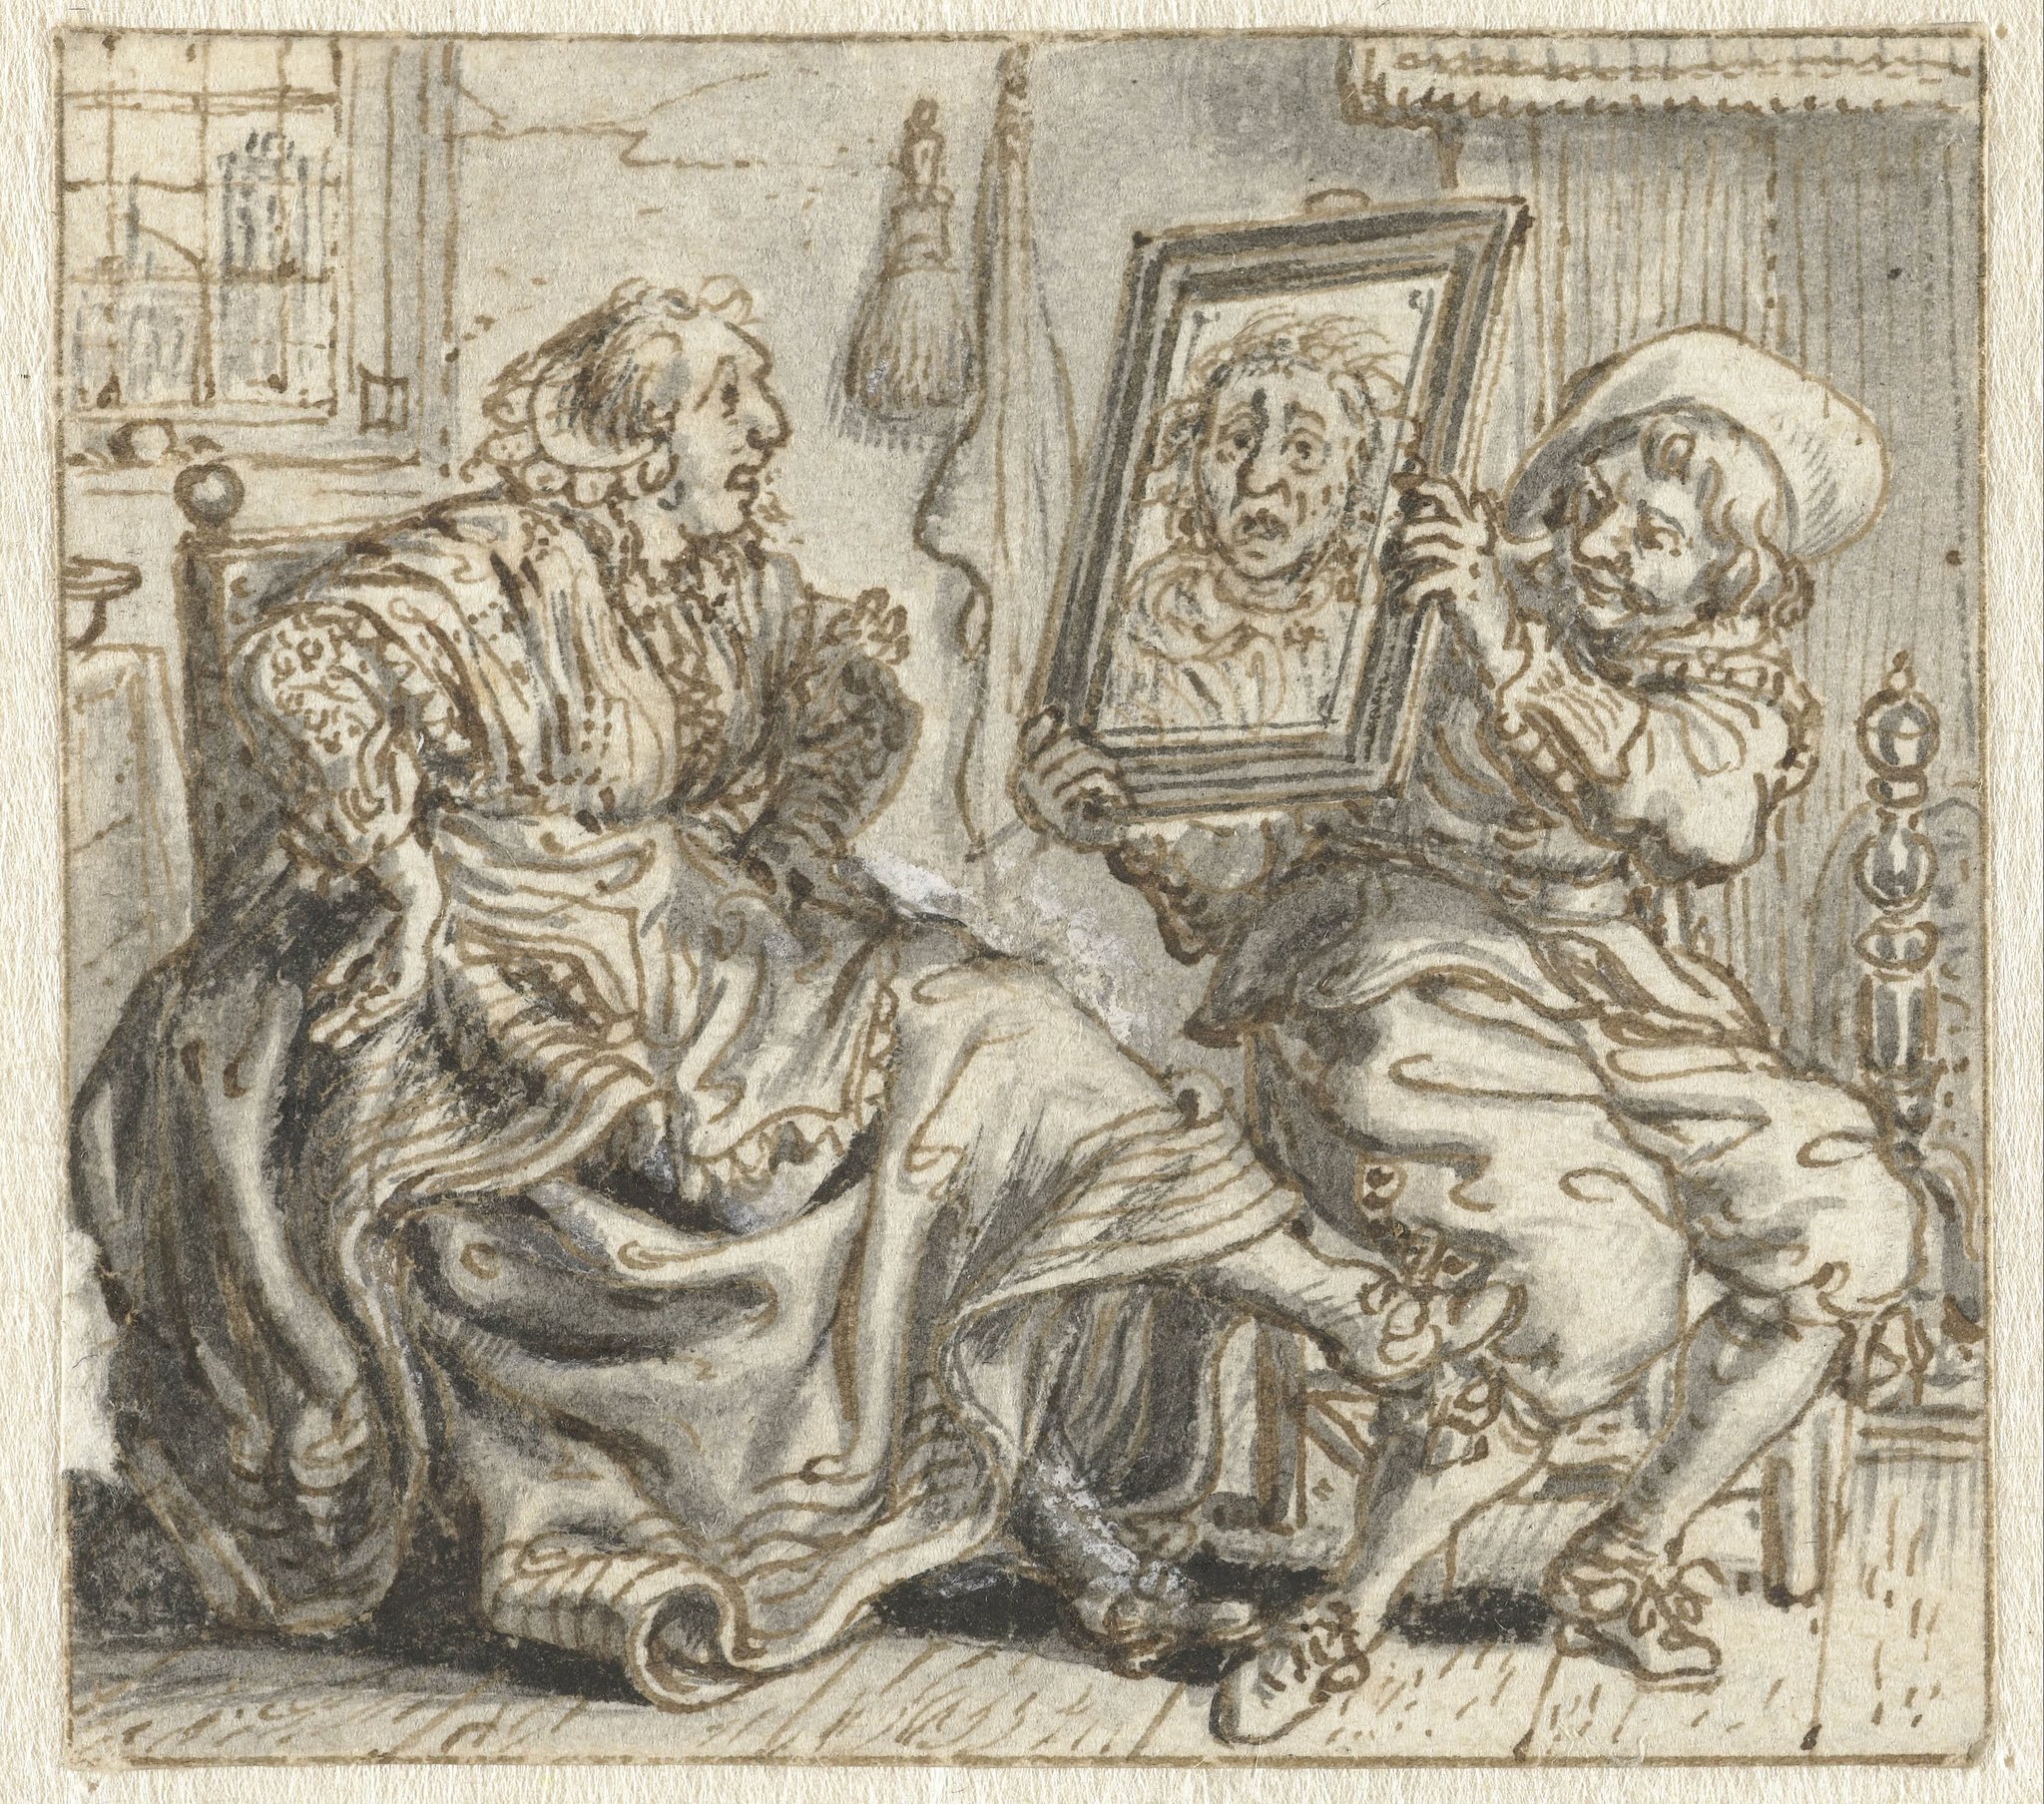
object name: design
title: Man Holding a Mirror up to his Wife’s Face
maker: adriaen pietersz van de venne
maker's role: draughtsman, painter, print maker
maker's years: 1589-1662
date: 1634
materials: paint, ink, paper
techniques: brush, pen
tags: looking in the mirror; contemplation of own beauty, marriage, married couple, 'matrimonium', (scenes from) specific works of literature (with author, title)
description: Ontwerp voor een illustratie in Jacob Cats' 'Hovwelyck ...' van 1634: een man houdt zijn vrouw een spiegel voor.